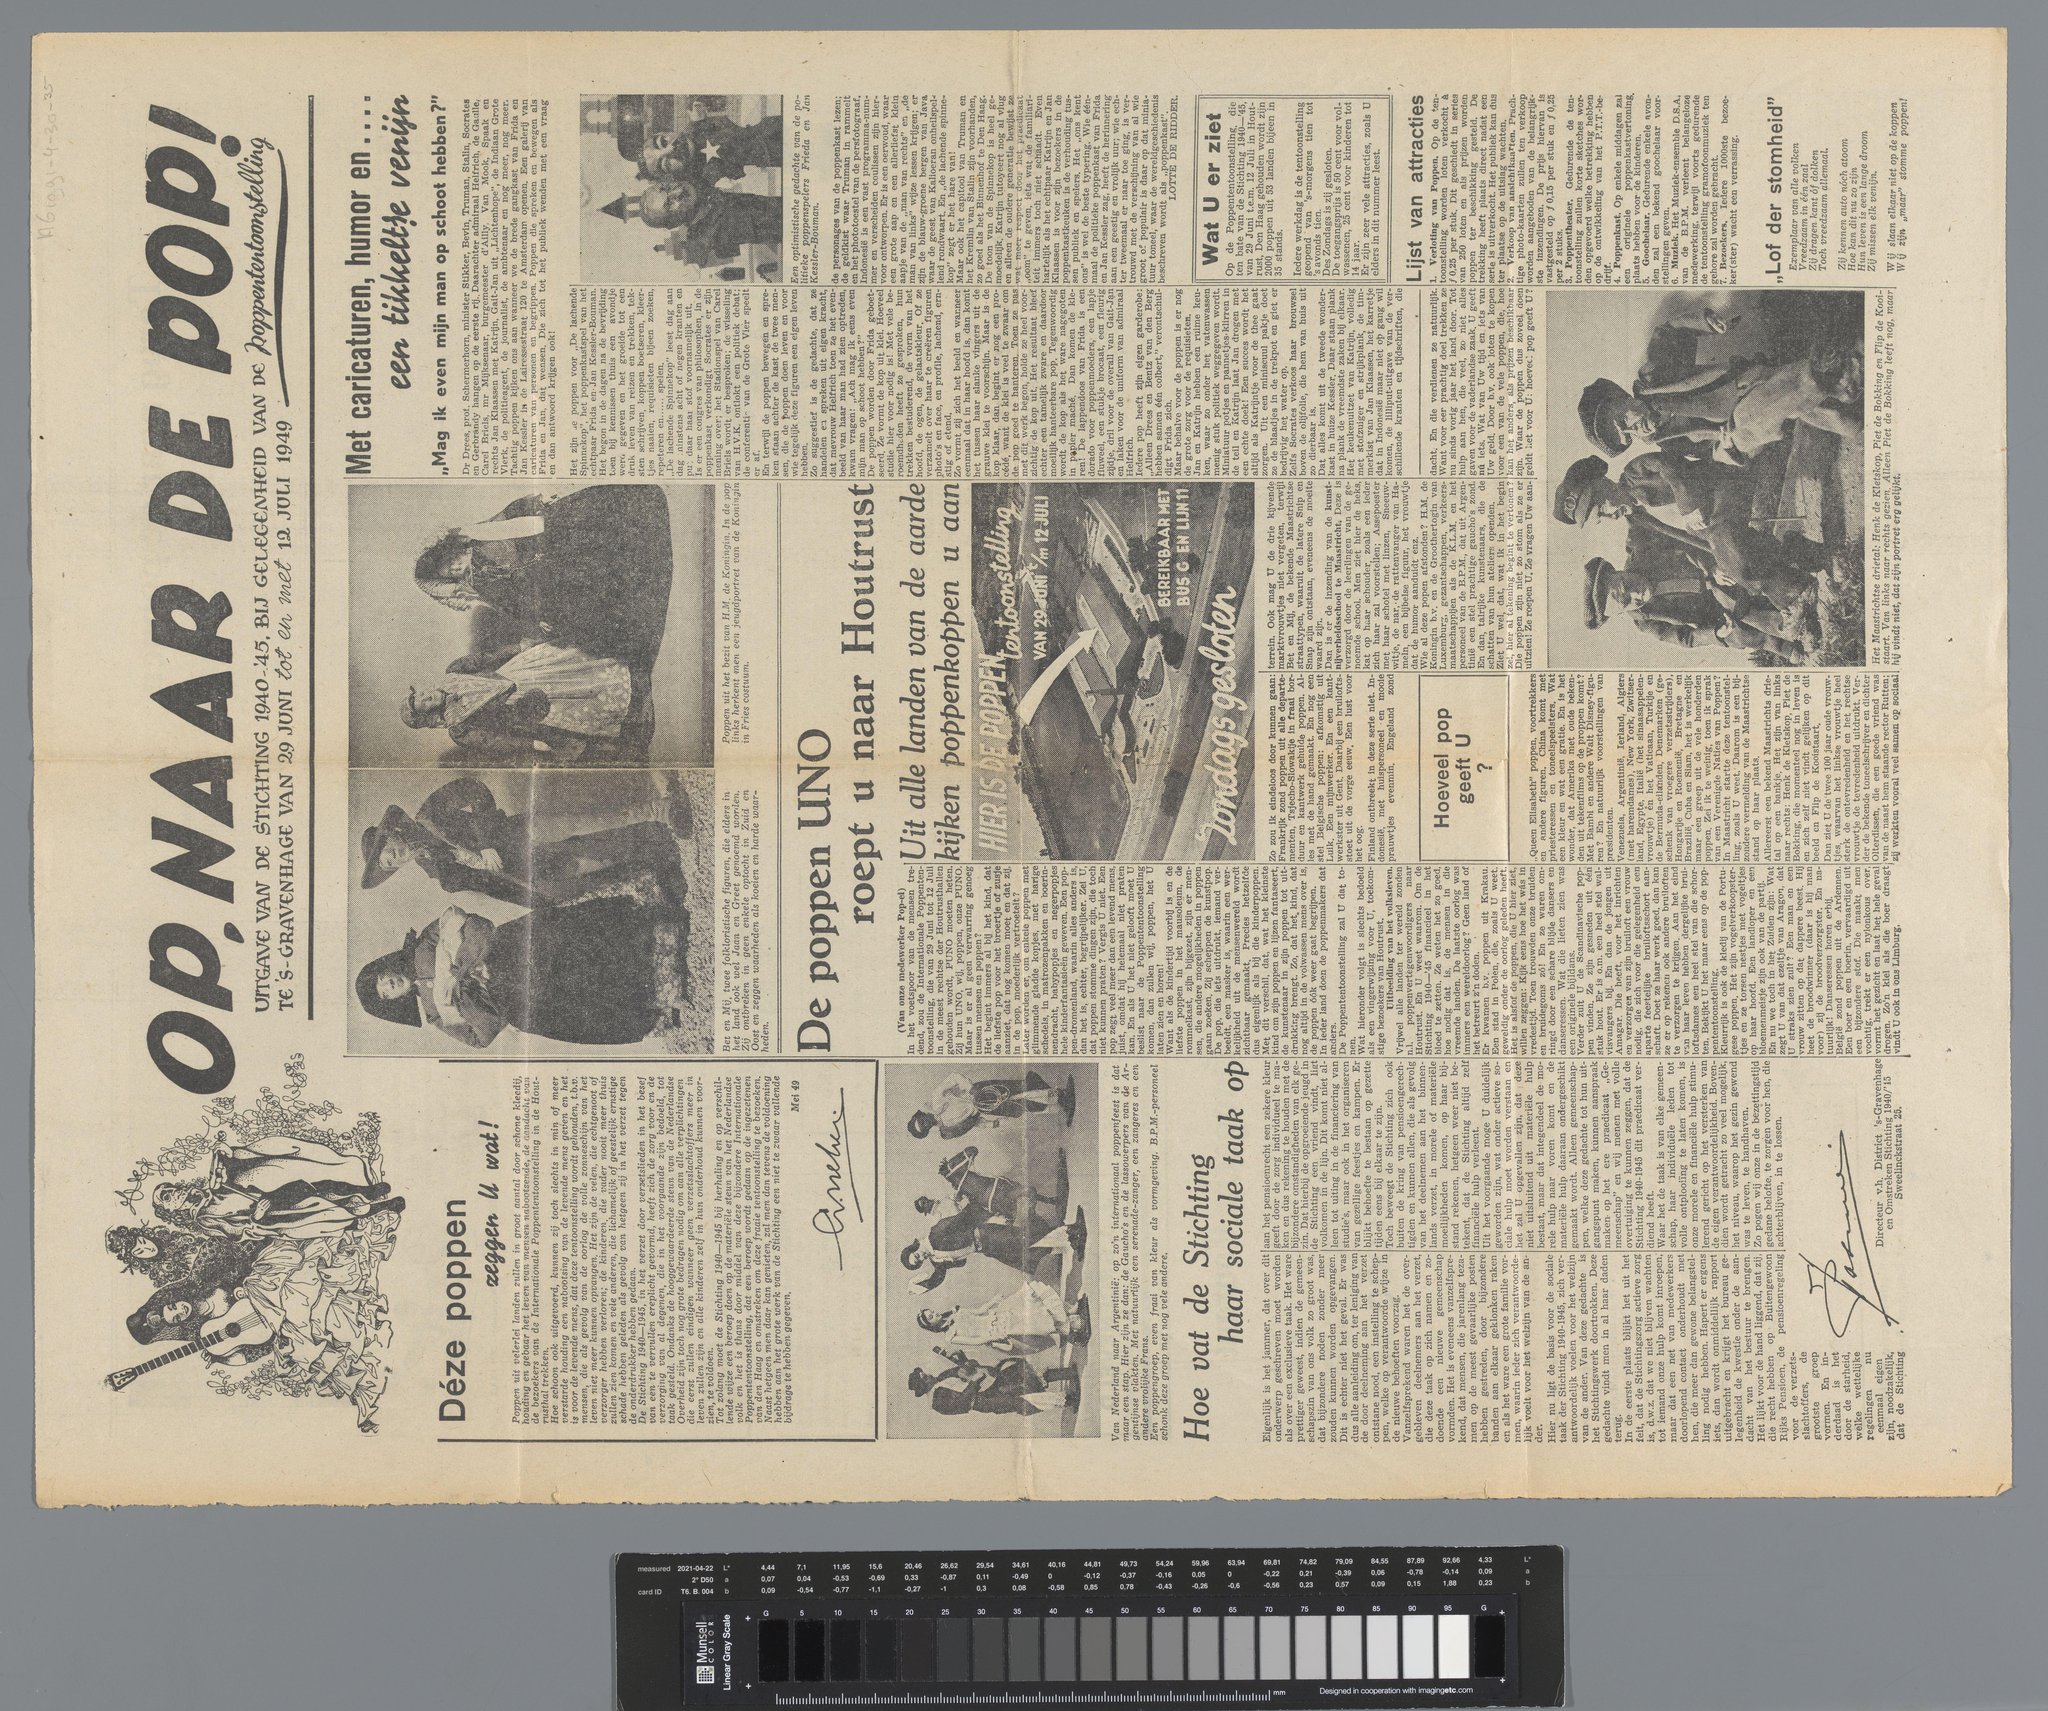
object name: newspaper clipping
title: Op, naar de pop! Uitgave van de Stichting 1940-'45, bij gelegenheid van de poppententoonstelling te 's-Gravenhage van 29 juni tot en met 12 juli 1949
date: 1905-1949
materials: paper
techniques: printing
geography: the hague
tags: amsterdam, willem drees, dolls for adults, temporary exhibition, 'salon', the hague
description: Bijlage over de poppententoonstelling bij de Nieuwe Haagsche Courant, mei 1949. Deel van een krant, los achterin het fotoalbum van de Poppententoonstelling in juni-juli 1949 van de Stichting 1940-1945, aangeboden aan premier Willem Drees.